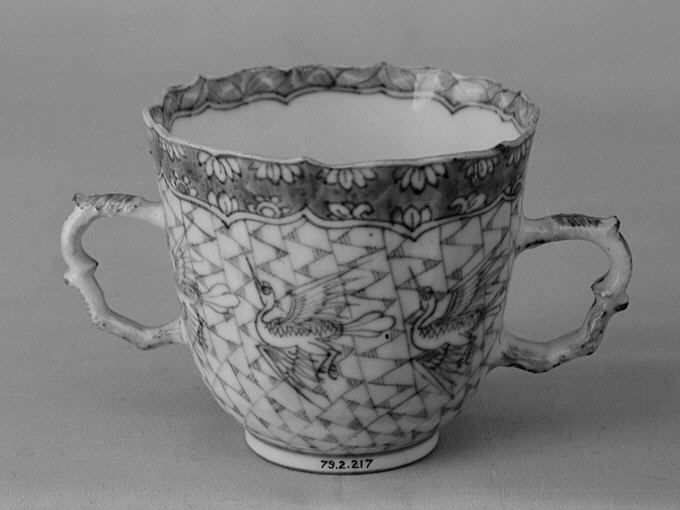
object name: cup and saucer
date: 1740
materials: hard paste porcelain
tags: birds